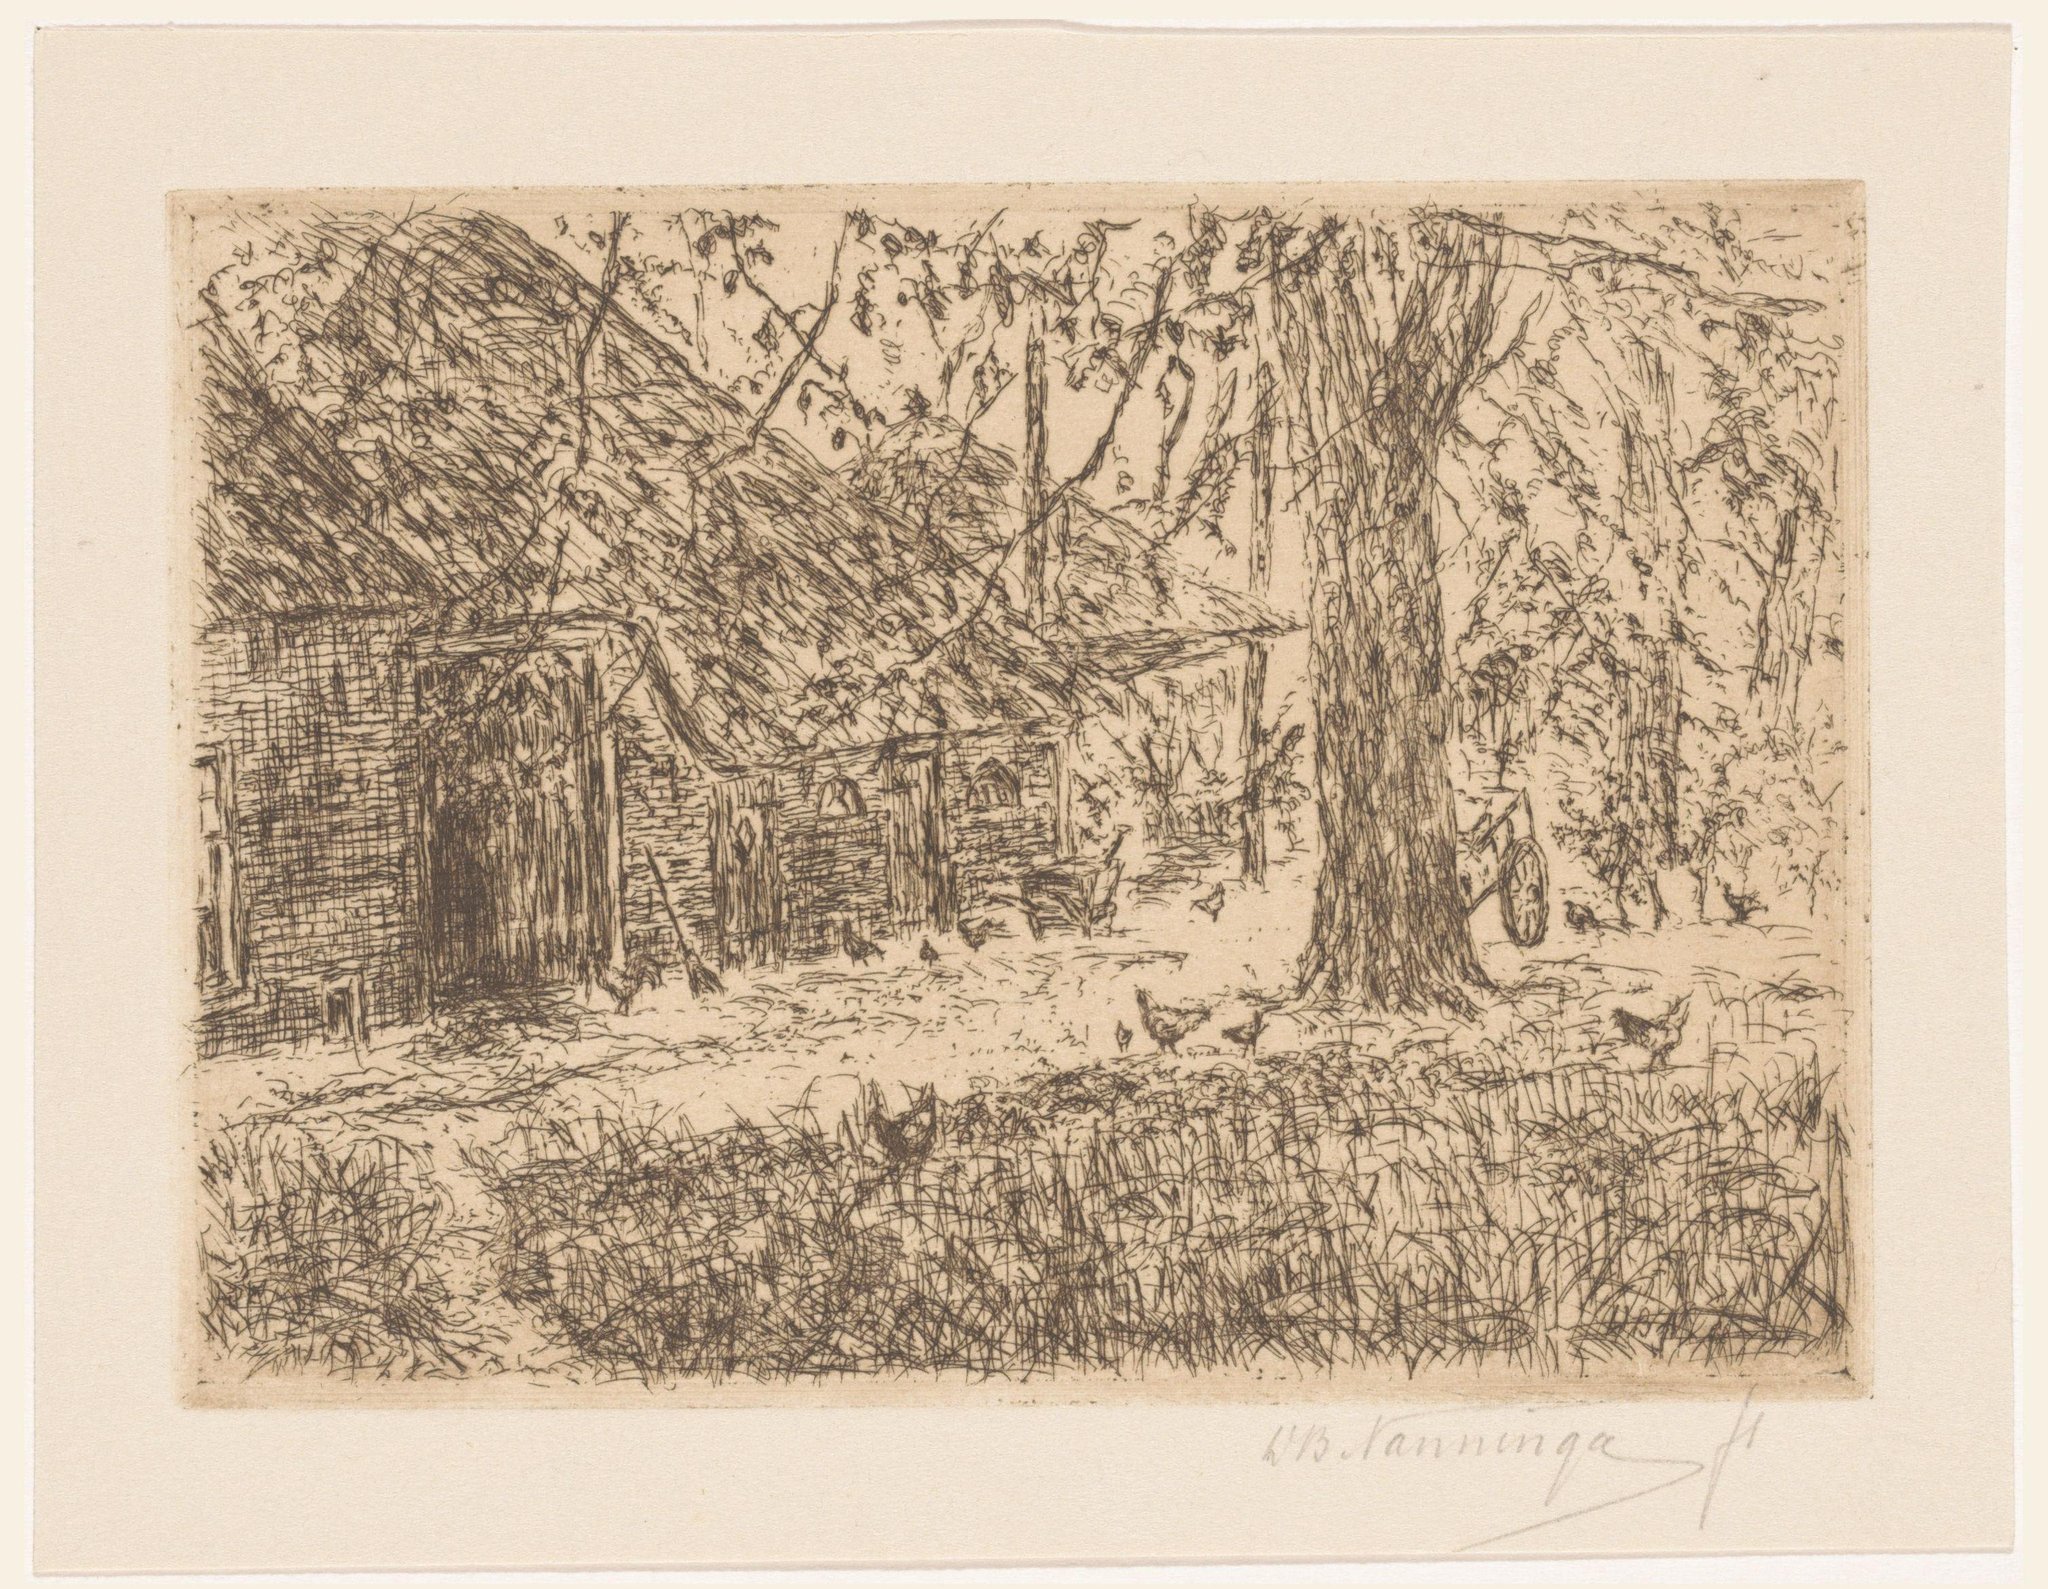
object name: print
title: Boerenerf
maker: dirk berend nanninga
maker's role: print maker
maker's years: 1868-1954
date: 1878-1931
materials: paper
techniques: etching, intaglio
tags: fowl (cock, hen, chicken, etc.), farm or solitary house in landscape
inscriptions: collector's mark: Lugt 2228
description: Links een schuur en een hooiberg; rechts een boom en een kar. Over het erf lopen kippen.